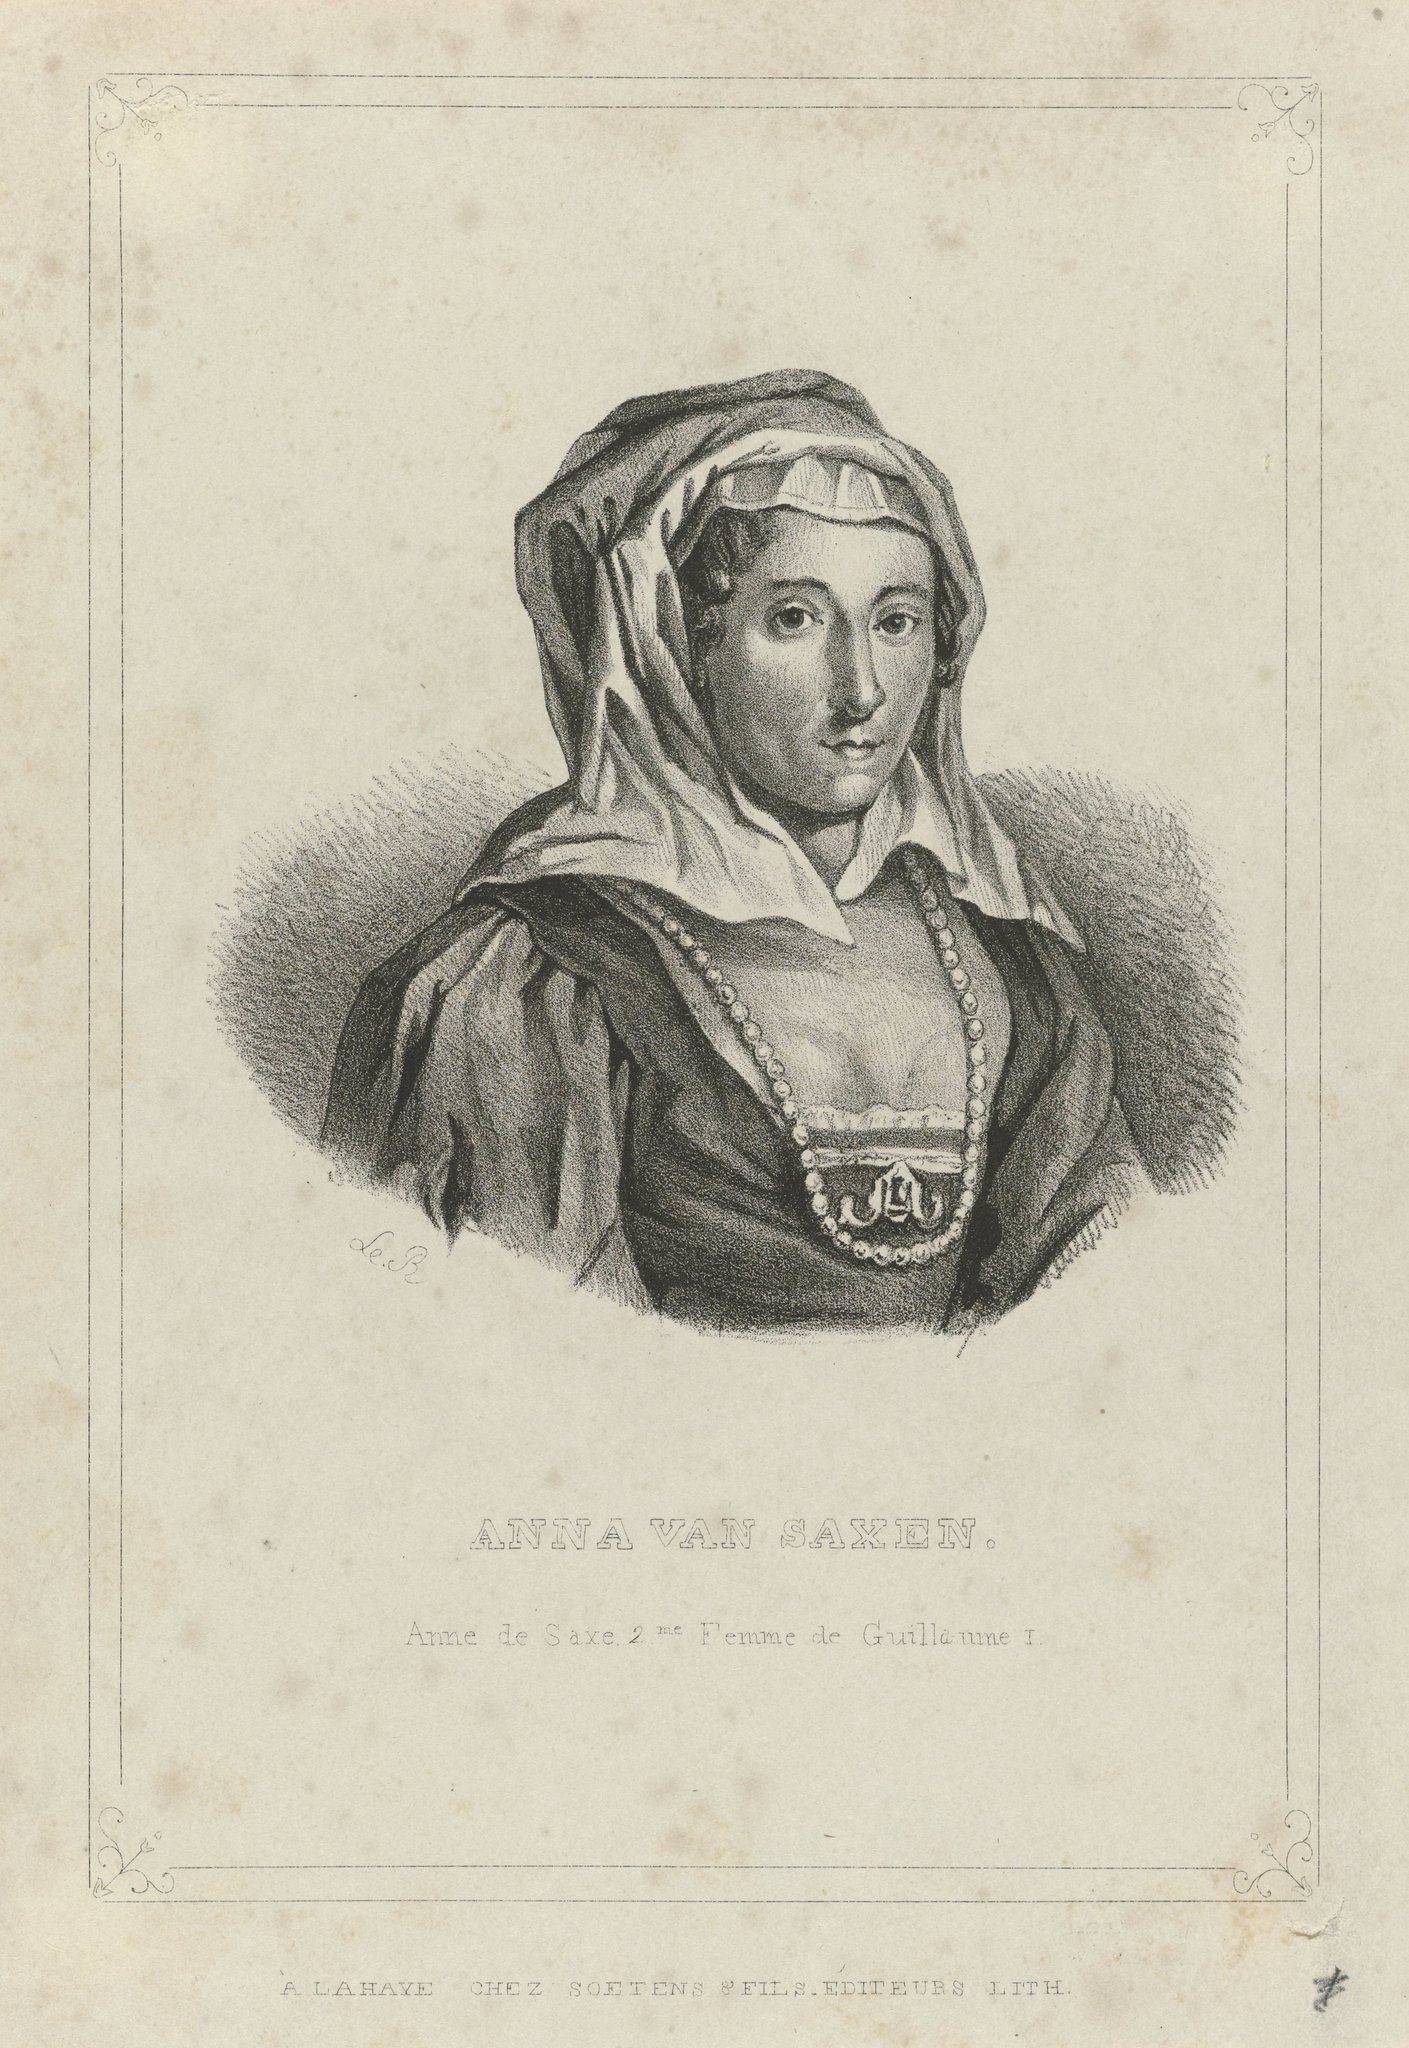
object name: print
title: Portret van Anna van Saksen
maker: le r.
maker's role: print maker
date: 1837-1840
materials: paper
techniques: lithograph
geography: the hague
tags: dresden, anna van saksen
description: Portret van Anna in een geornamenteerde rechthoek. In de ondermarge haar naam.